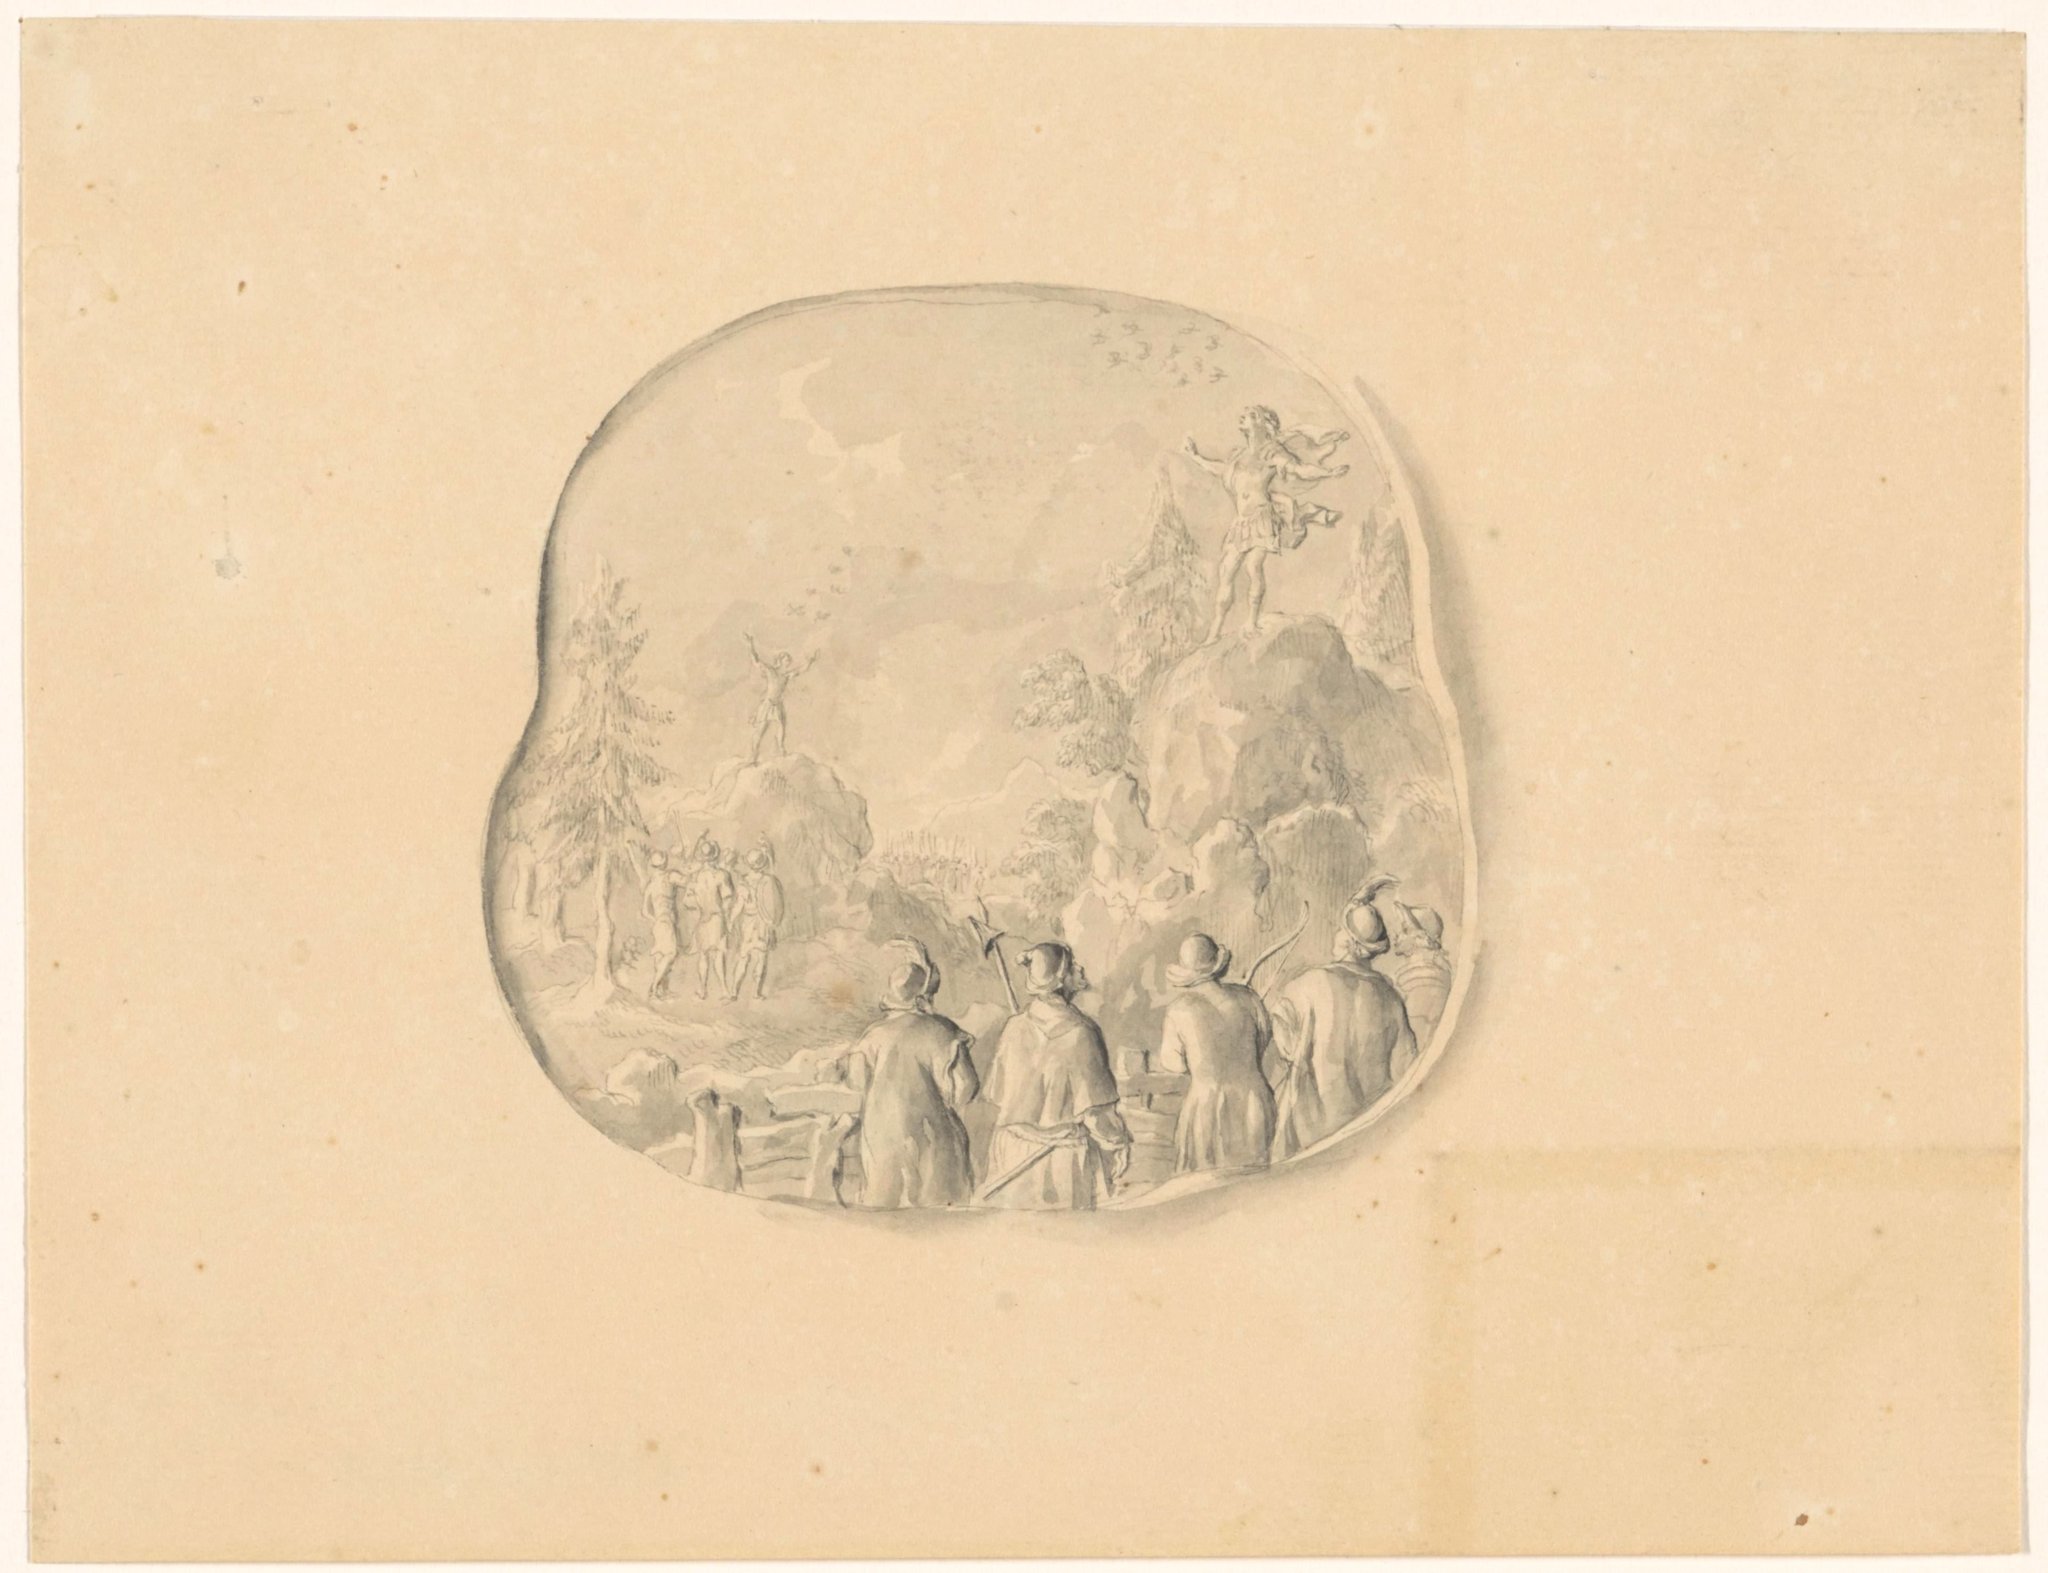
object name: album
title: Tekening van 17e eeuws zilver behorende bij een album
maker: Anonymous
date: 1725-1728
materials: paper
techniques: drawing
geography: amsterdam